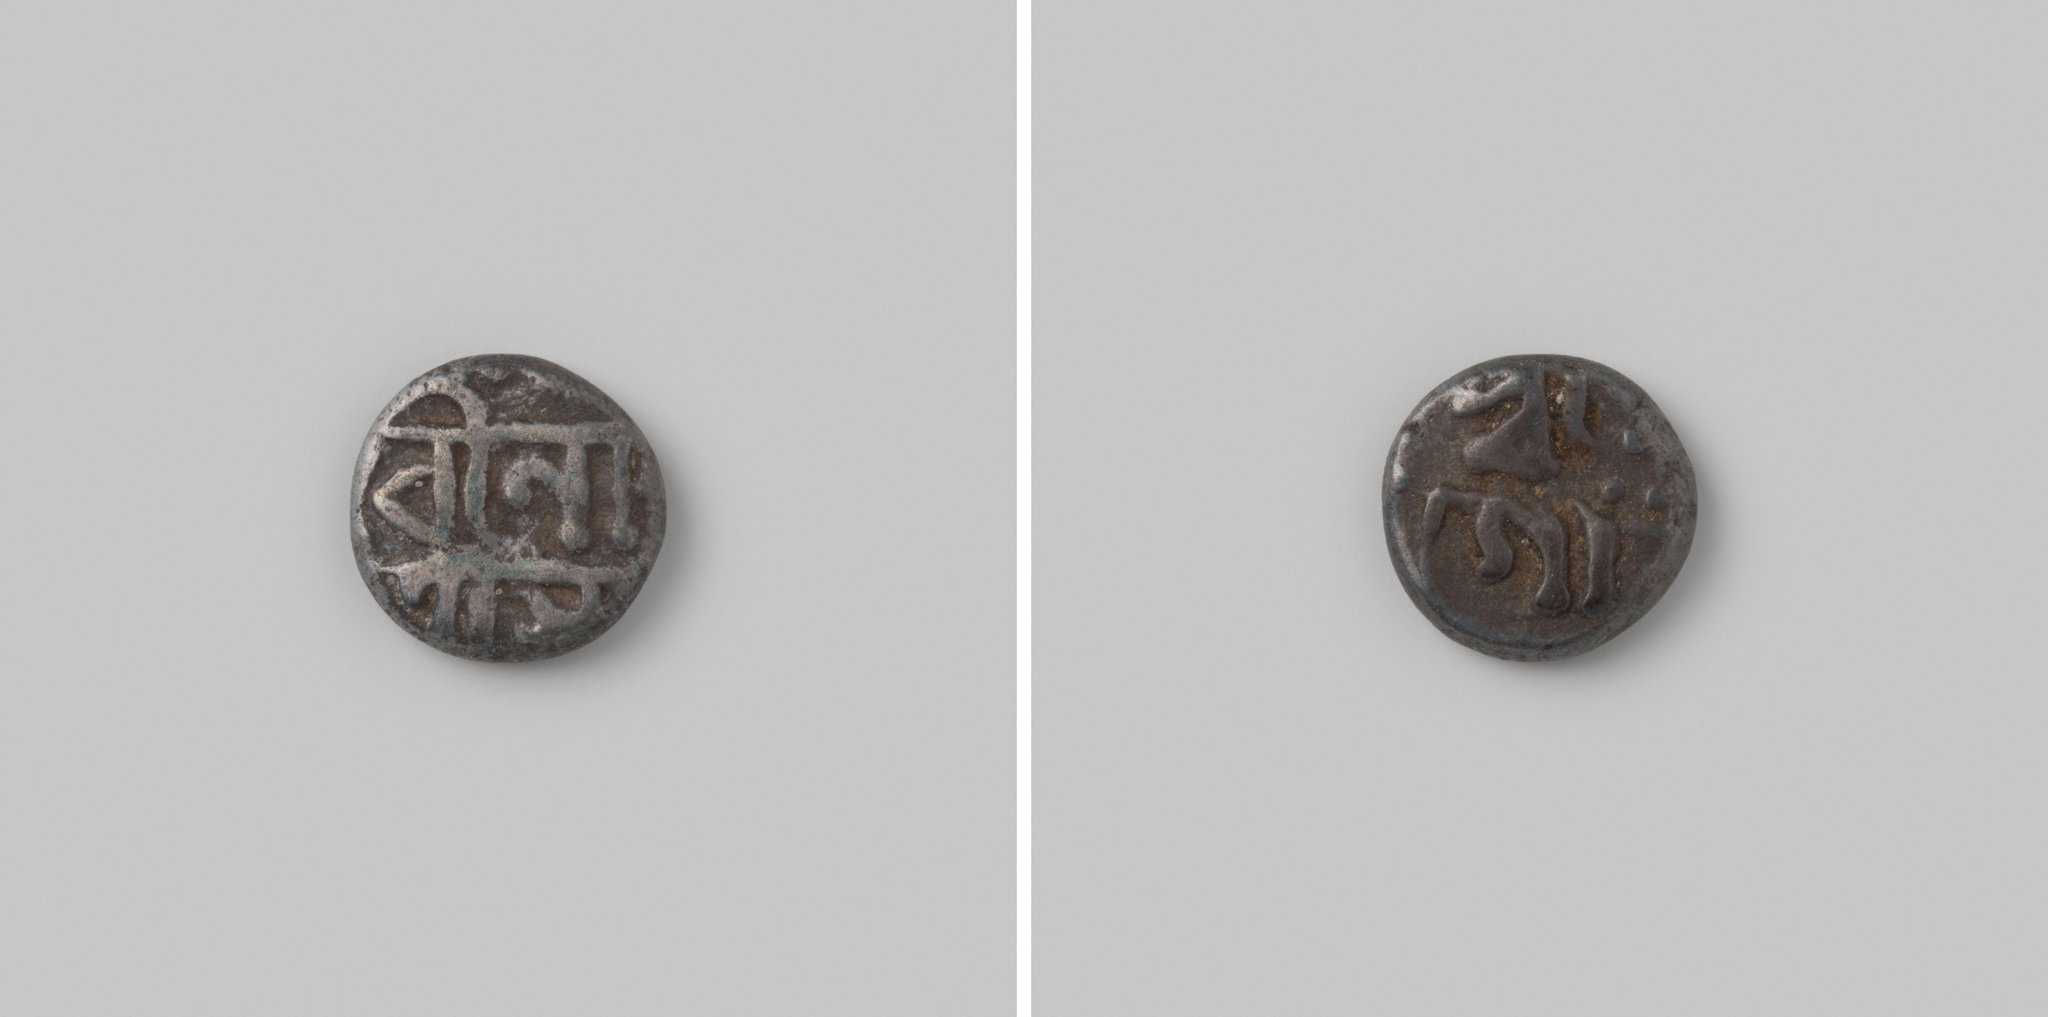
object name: coin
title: 1/32 roepie uit Assam in India van Gaurinatha Simha, 1780-1795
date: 1780-1795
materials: silver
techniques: striking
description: Zilveren munt. Voorzijde: in Nagari-schrift in twee regels naam van de vorst: Gaurinatha. Keerzijde: op twee regels onduidelijke lettertekens.